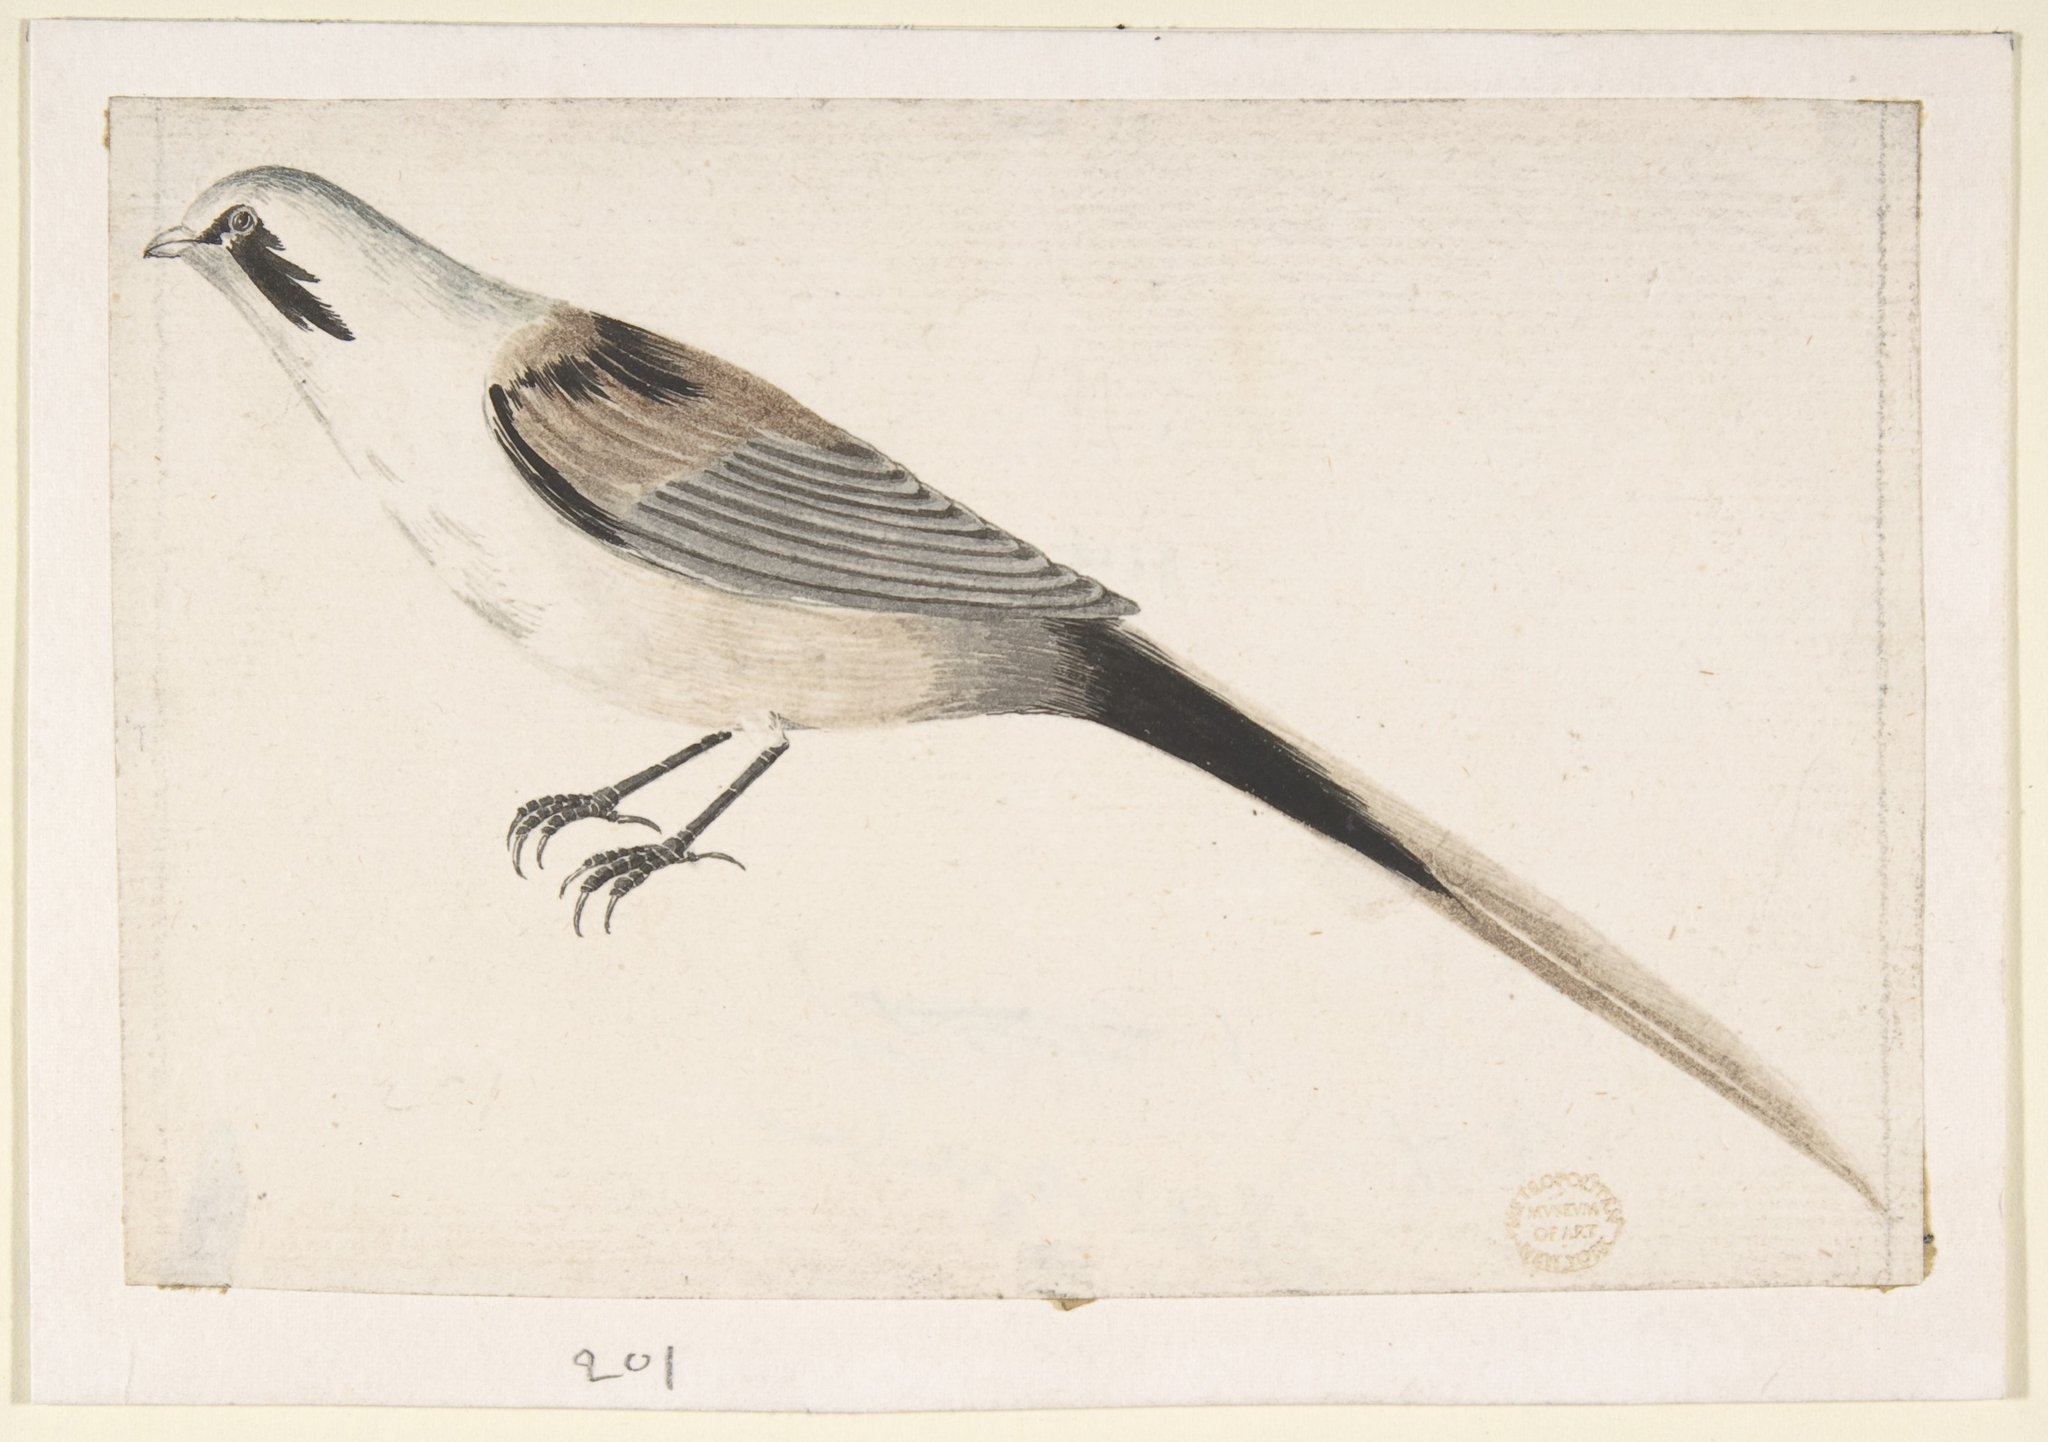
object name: drawing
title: Long-Tailed Bird Seen in Profile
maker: count giorgio durante (duranti)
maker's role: artist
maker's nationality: italian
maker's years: 1685-1755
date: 1701-1766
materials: graphite, watercolor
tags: birds